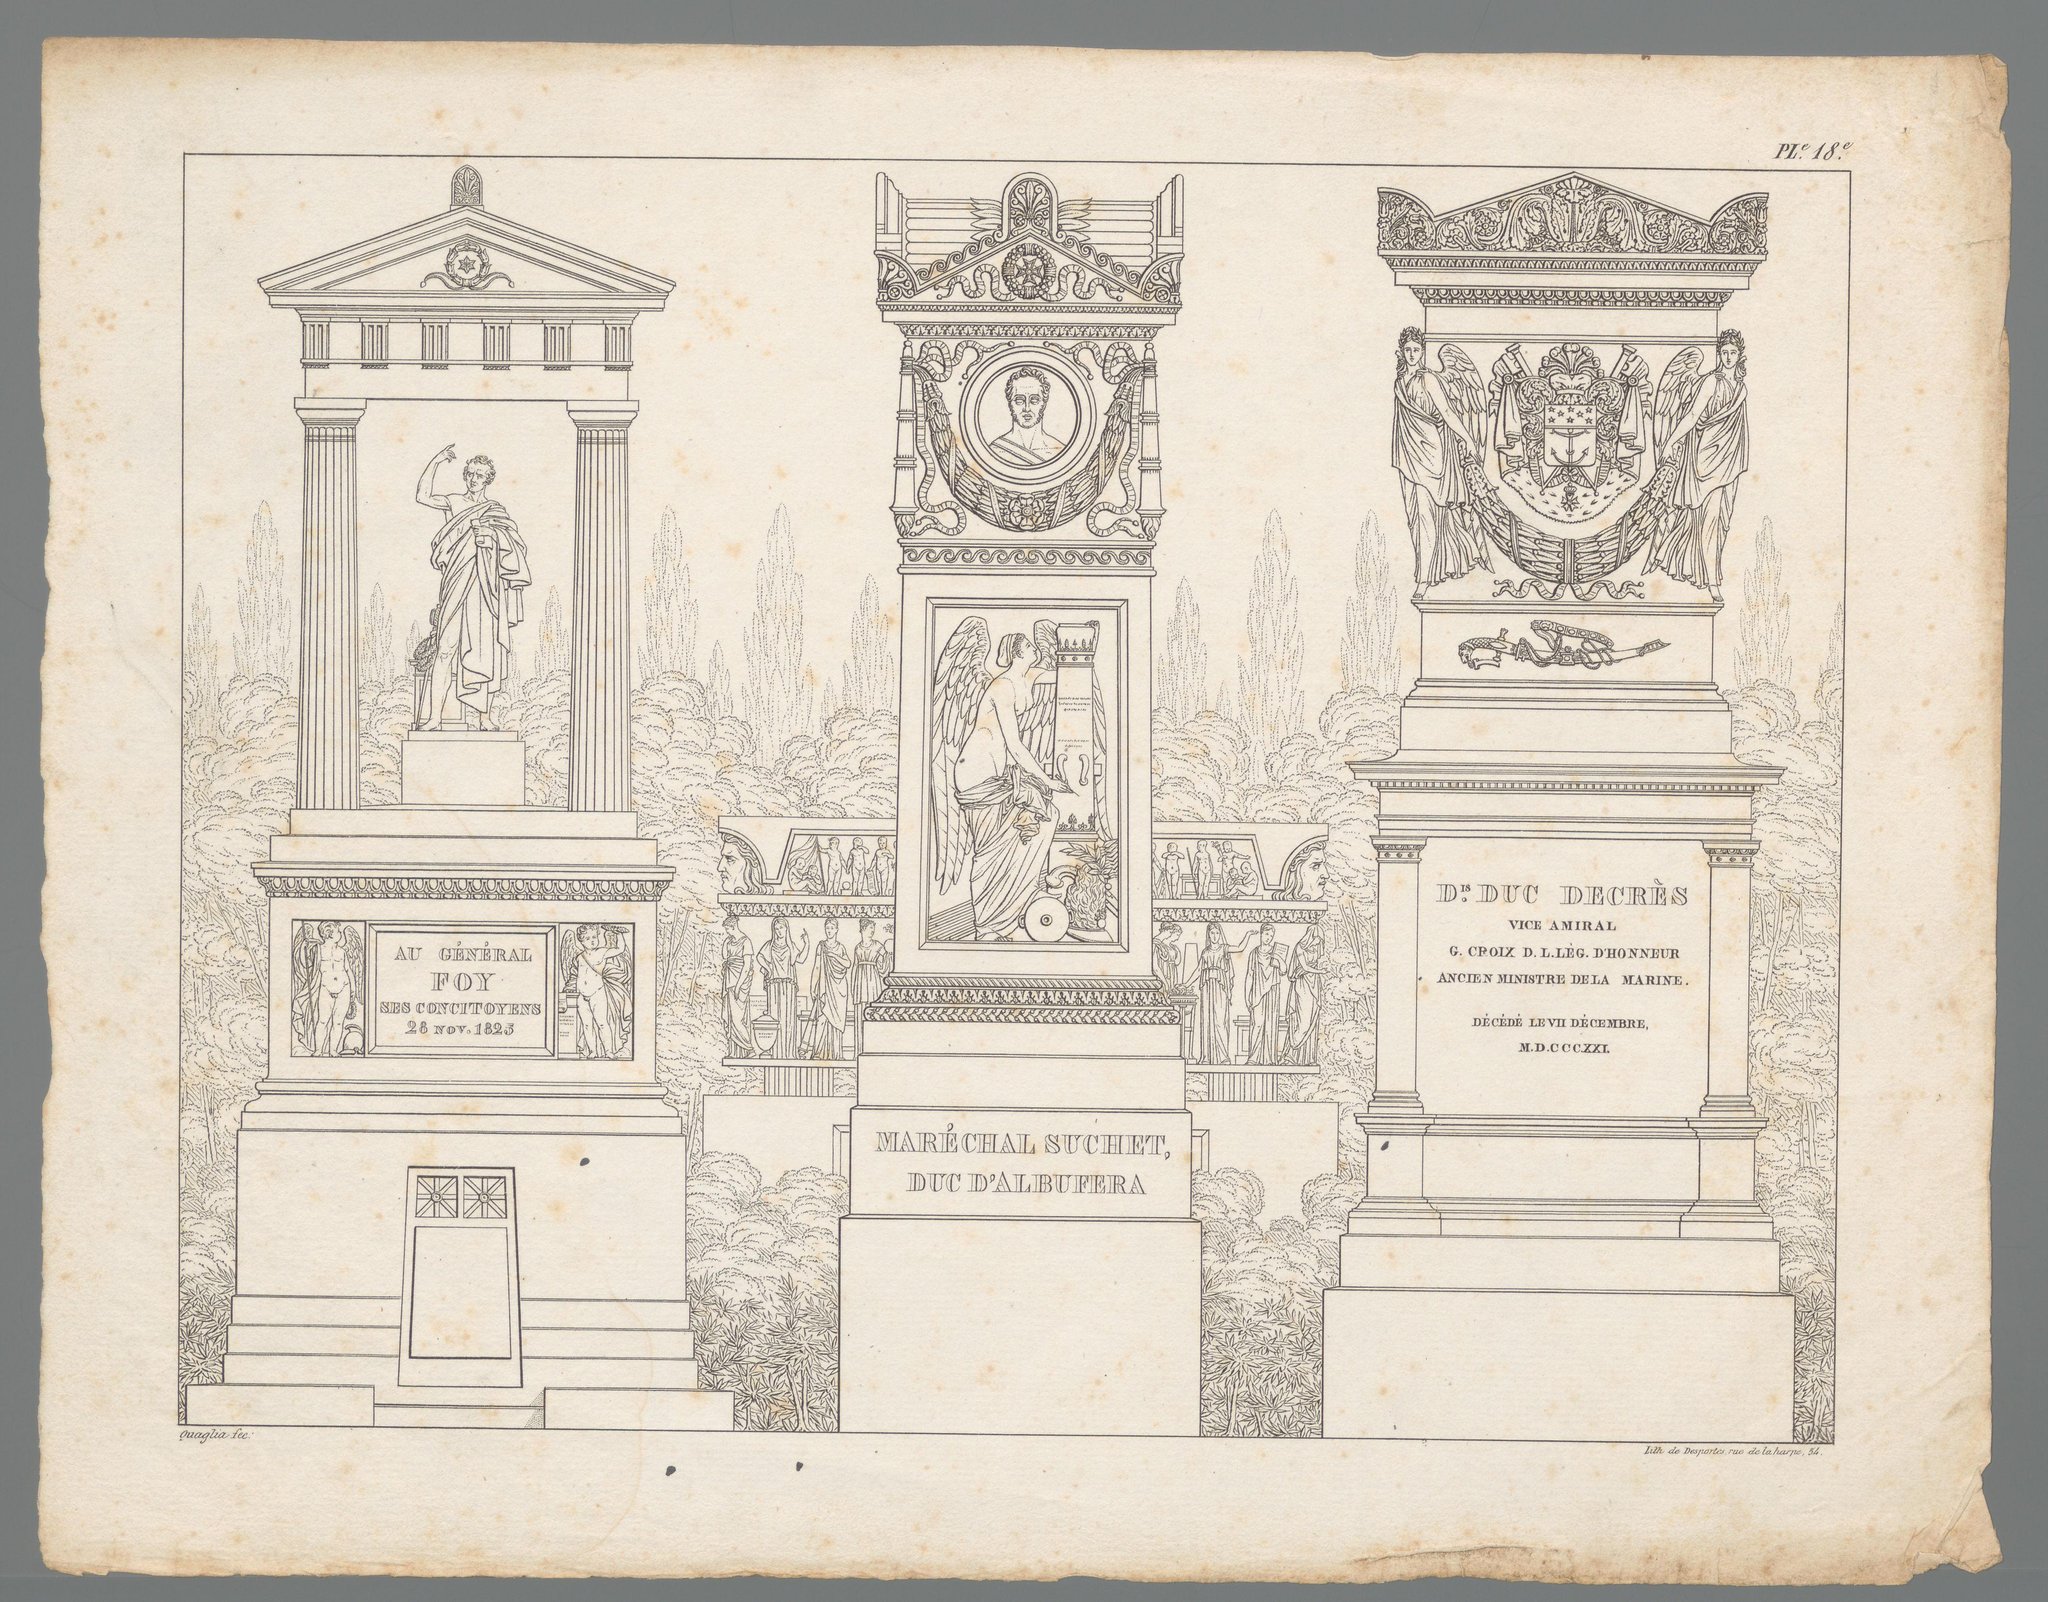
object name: print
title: Drie grafmonumenten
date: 1803-1869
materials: paper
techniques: lithograph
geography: paris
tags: cemetery, park-like burying ground